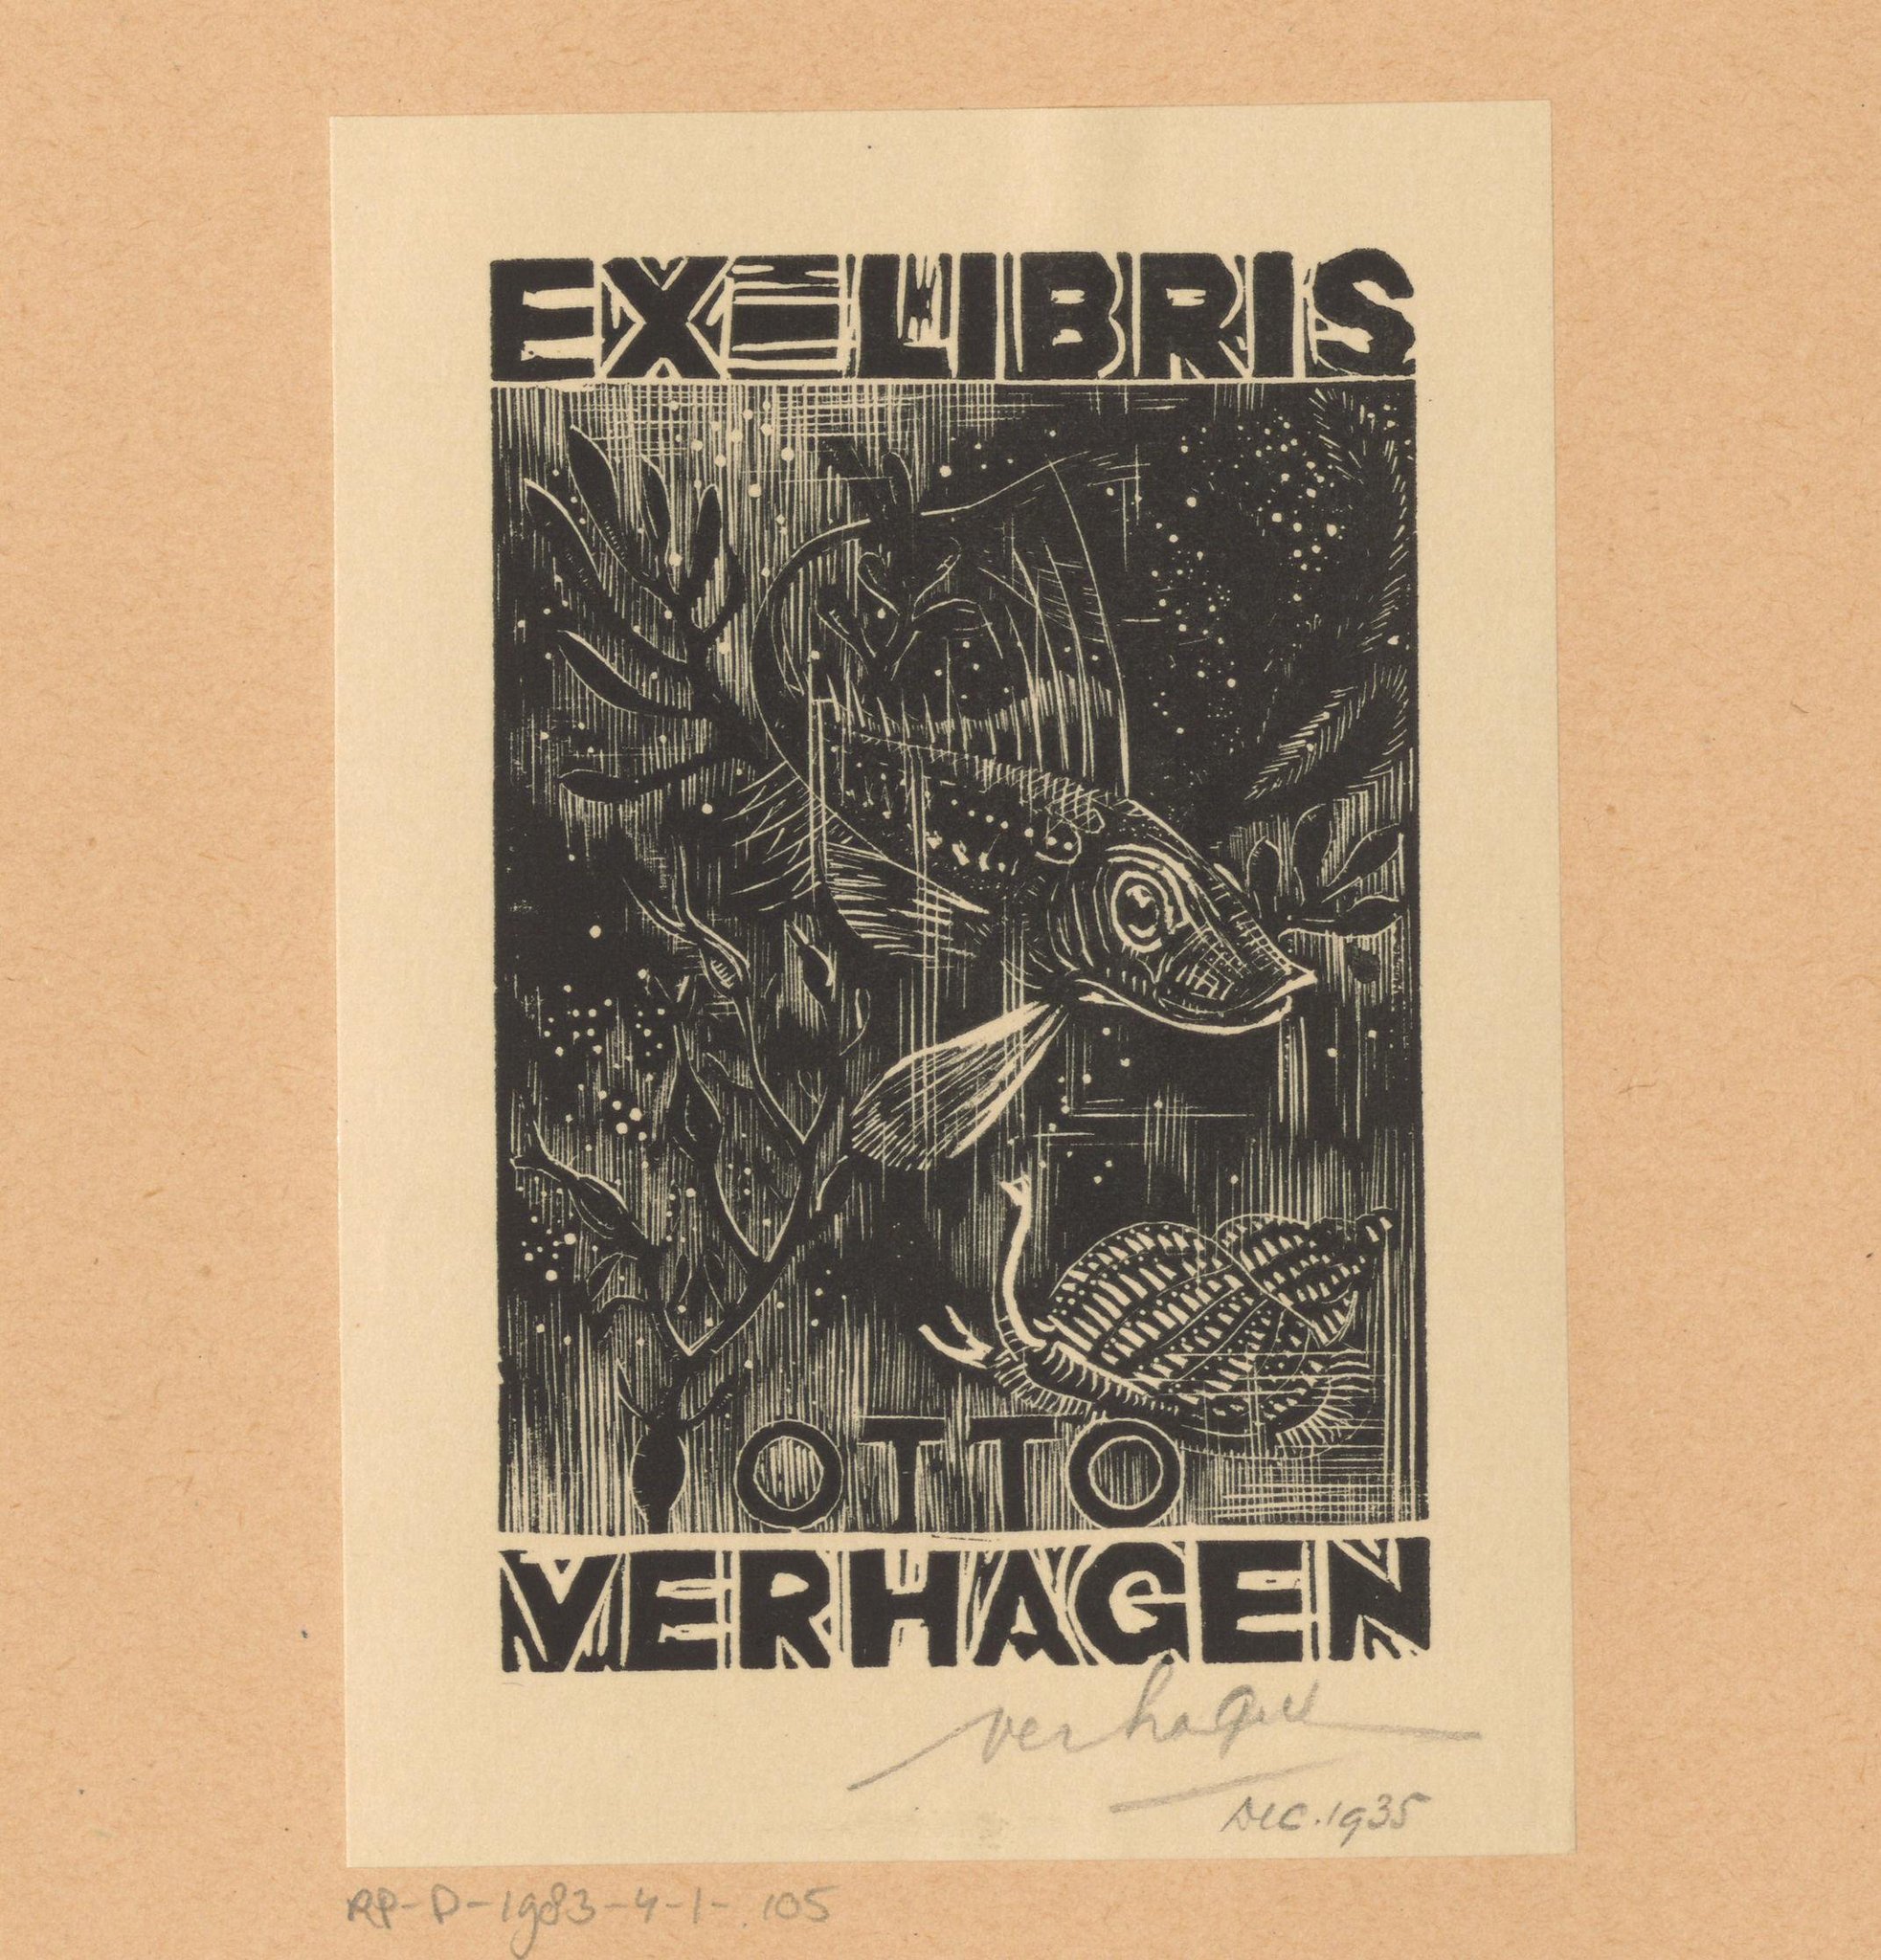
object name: bookplate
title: Ex libris van Otto Verhagen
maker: otto verhagen (i)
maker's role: draughtsman, print maker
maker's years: 1885-1951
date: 1935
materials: paper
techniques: woodcut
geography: netherlands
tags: print maker, draughtsman, otto verhagen (i), fishes, molluscs: snail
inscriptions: signature and date: ‘Verhagen/ Dec. 1935’, inscription: ‘Houtsnede (Kops-perenhout) (...) New York - 1950.’, inscription: ‘Druk op simili-japon’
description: Afgebeeld zijn diepzee fauna en flora. De prent is afgebeeld en besproken in D. Giltay Veth, "Dutch book plates", New York, 1950.